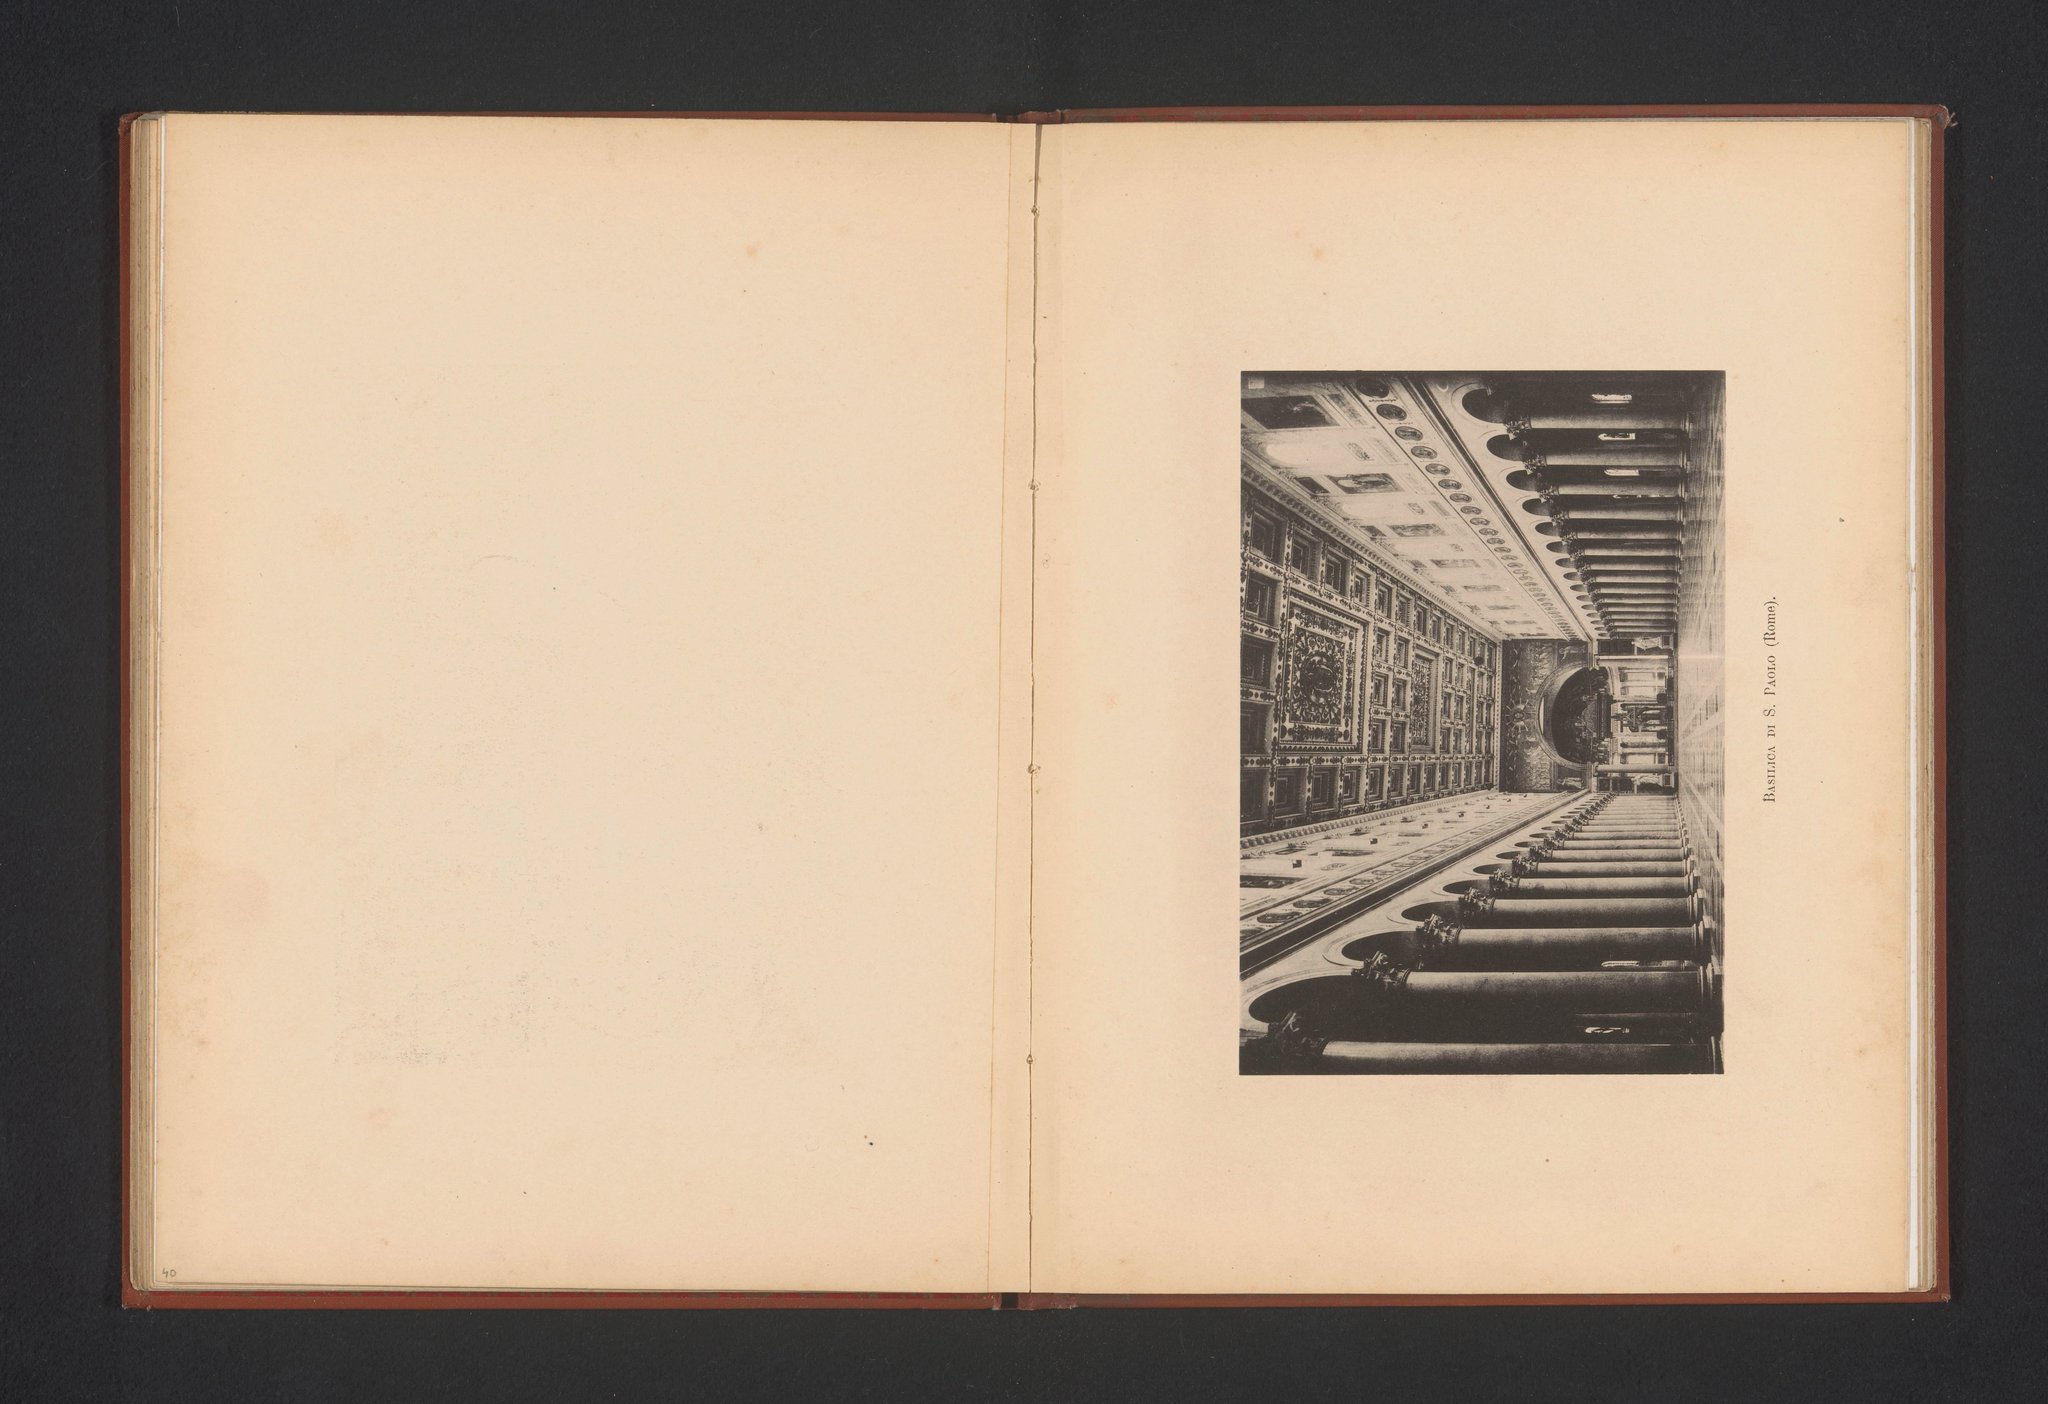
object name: page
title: Gezicht op het interieur van de Sint-Paulus buiten de Muren in Rome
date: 1893-1898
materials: paper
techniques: photograph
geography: rome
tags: parts of church interior: nave